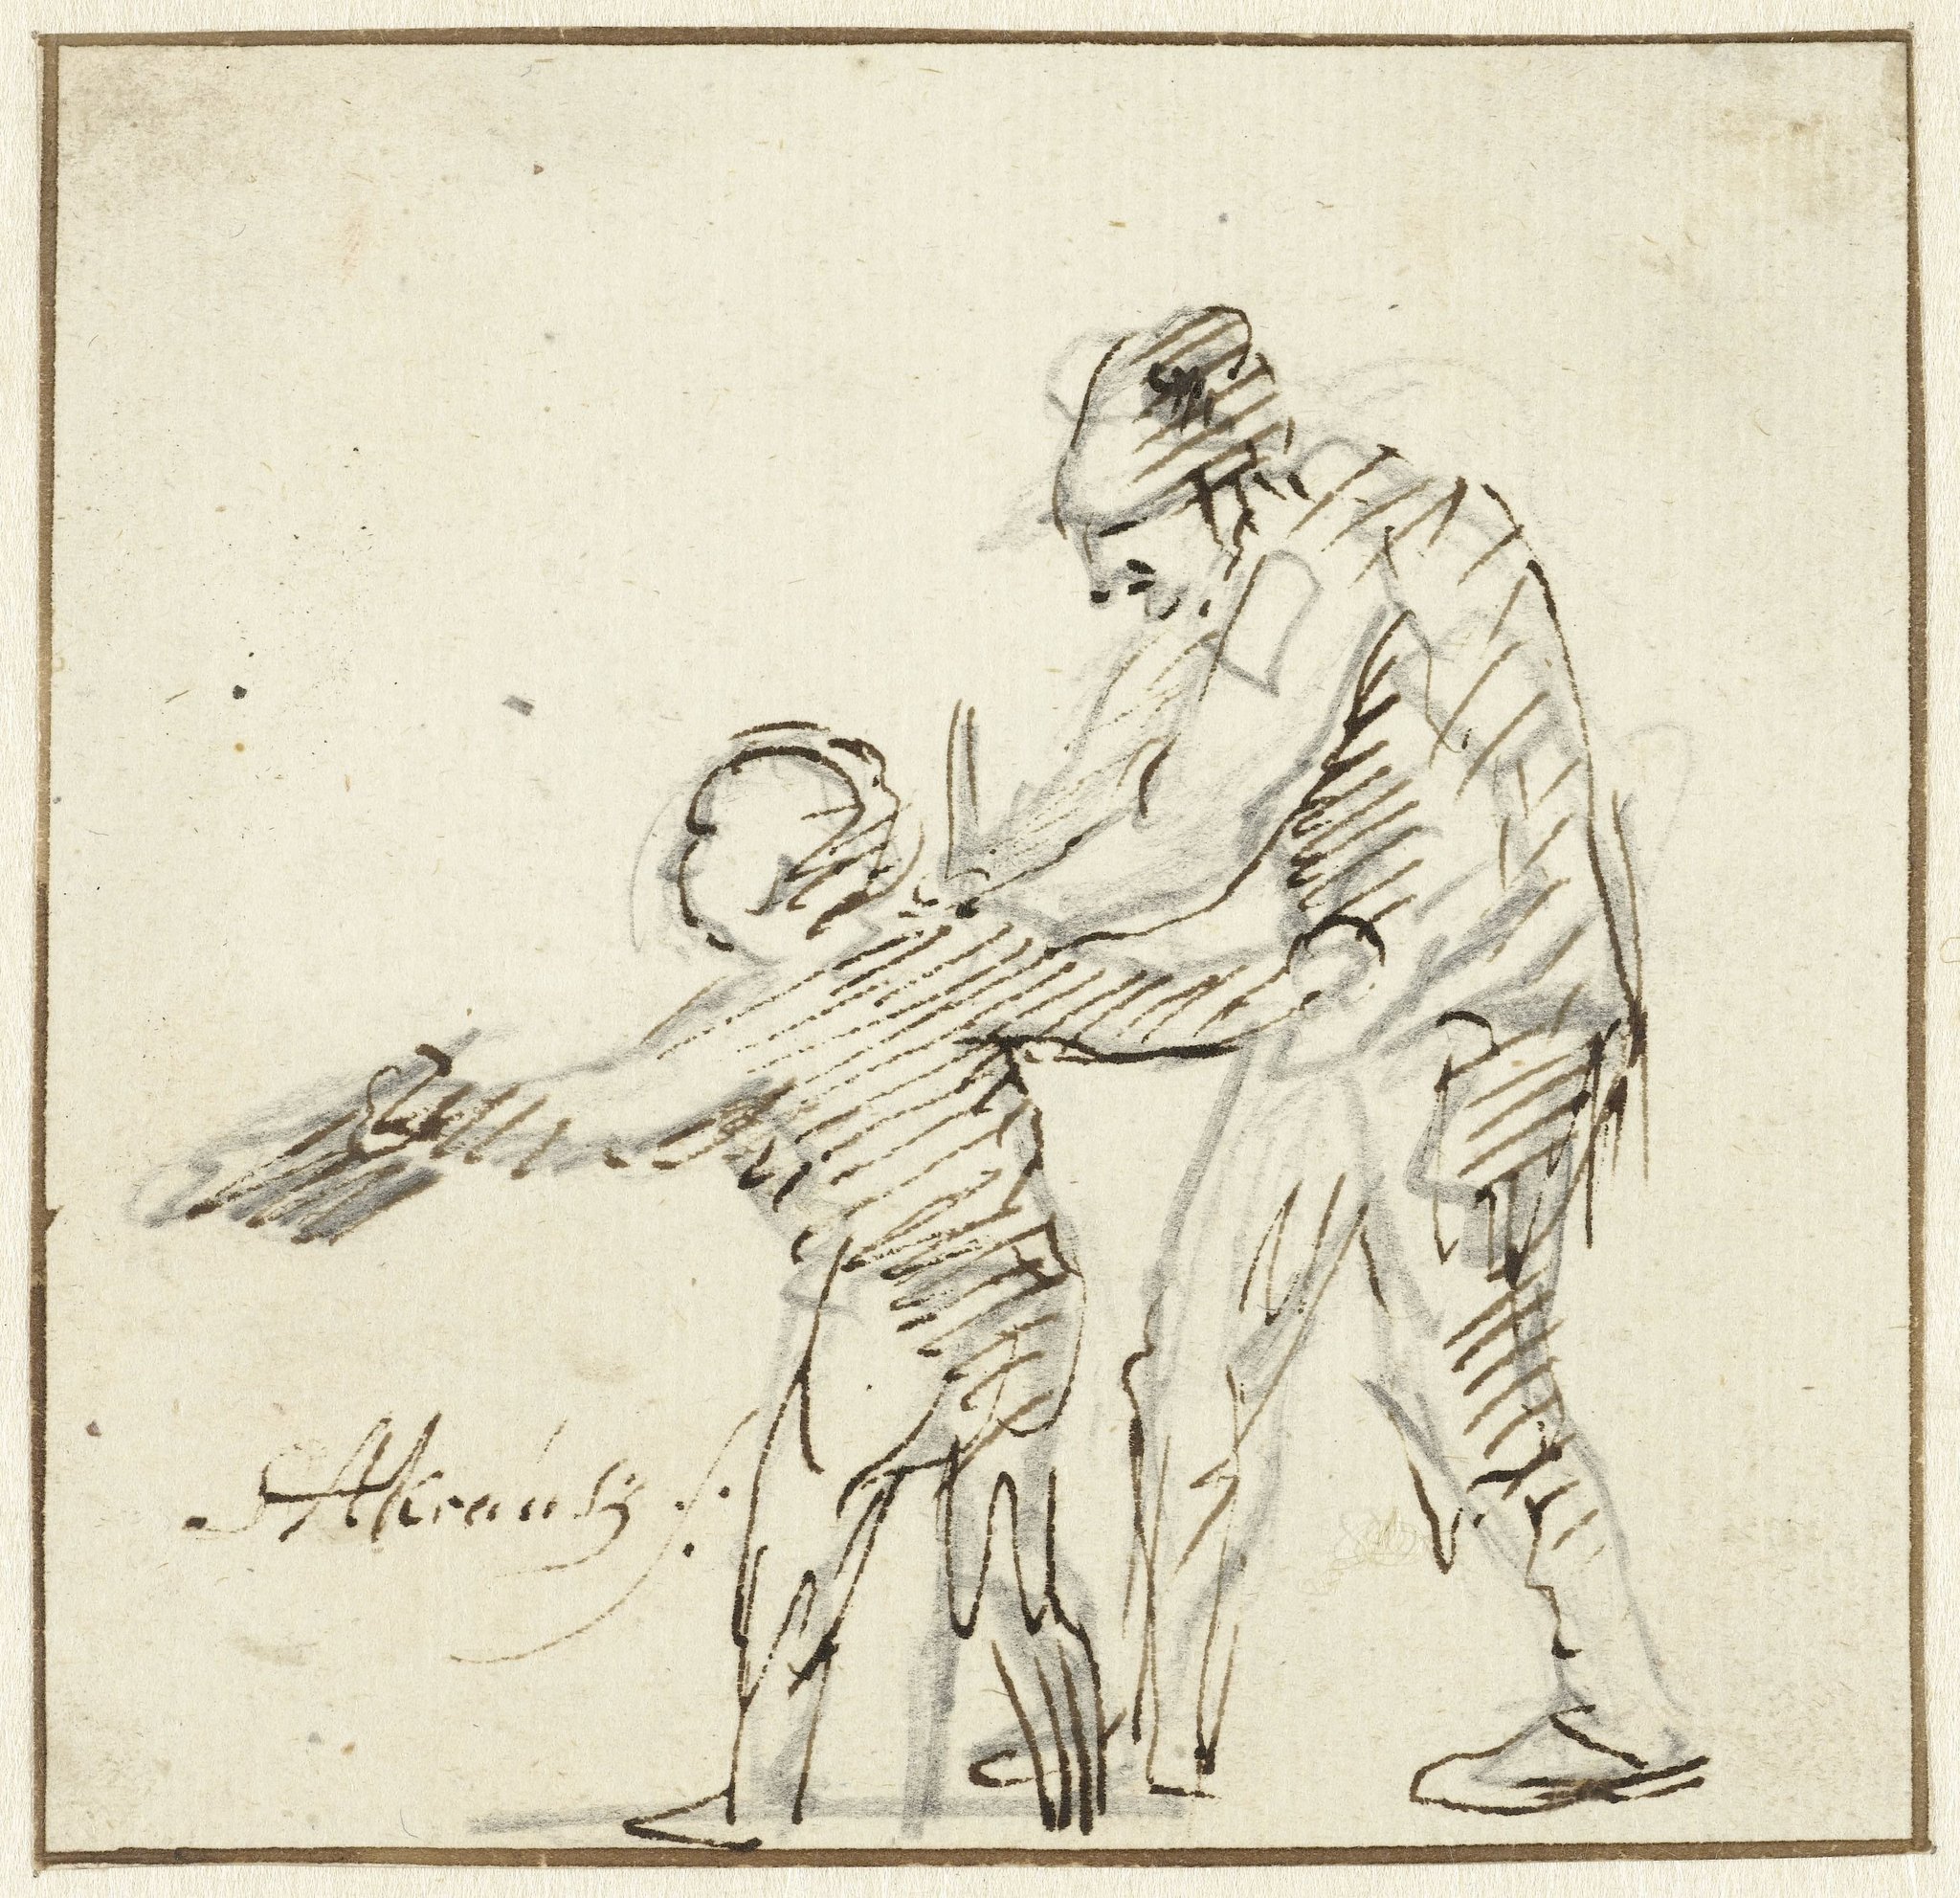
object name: drawing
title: Jongen een blinde bedelaar begeleidend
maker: simon andreas krausz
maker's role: draughtsman, print maker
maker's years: 1760-1825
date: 1770-1825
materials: ink, paper, pencil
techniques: pen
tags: beggar